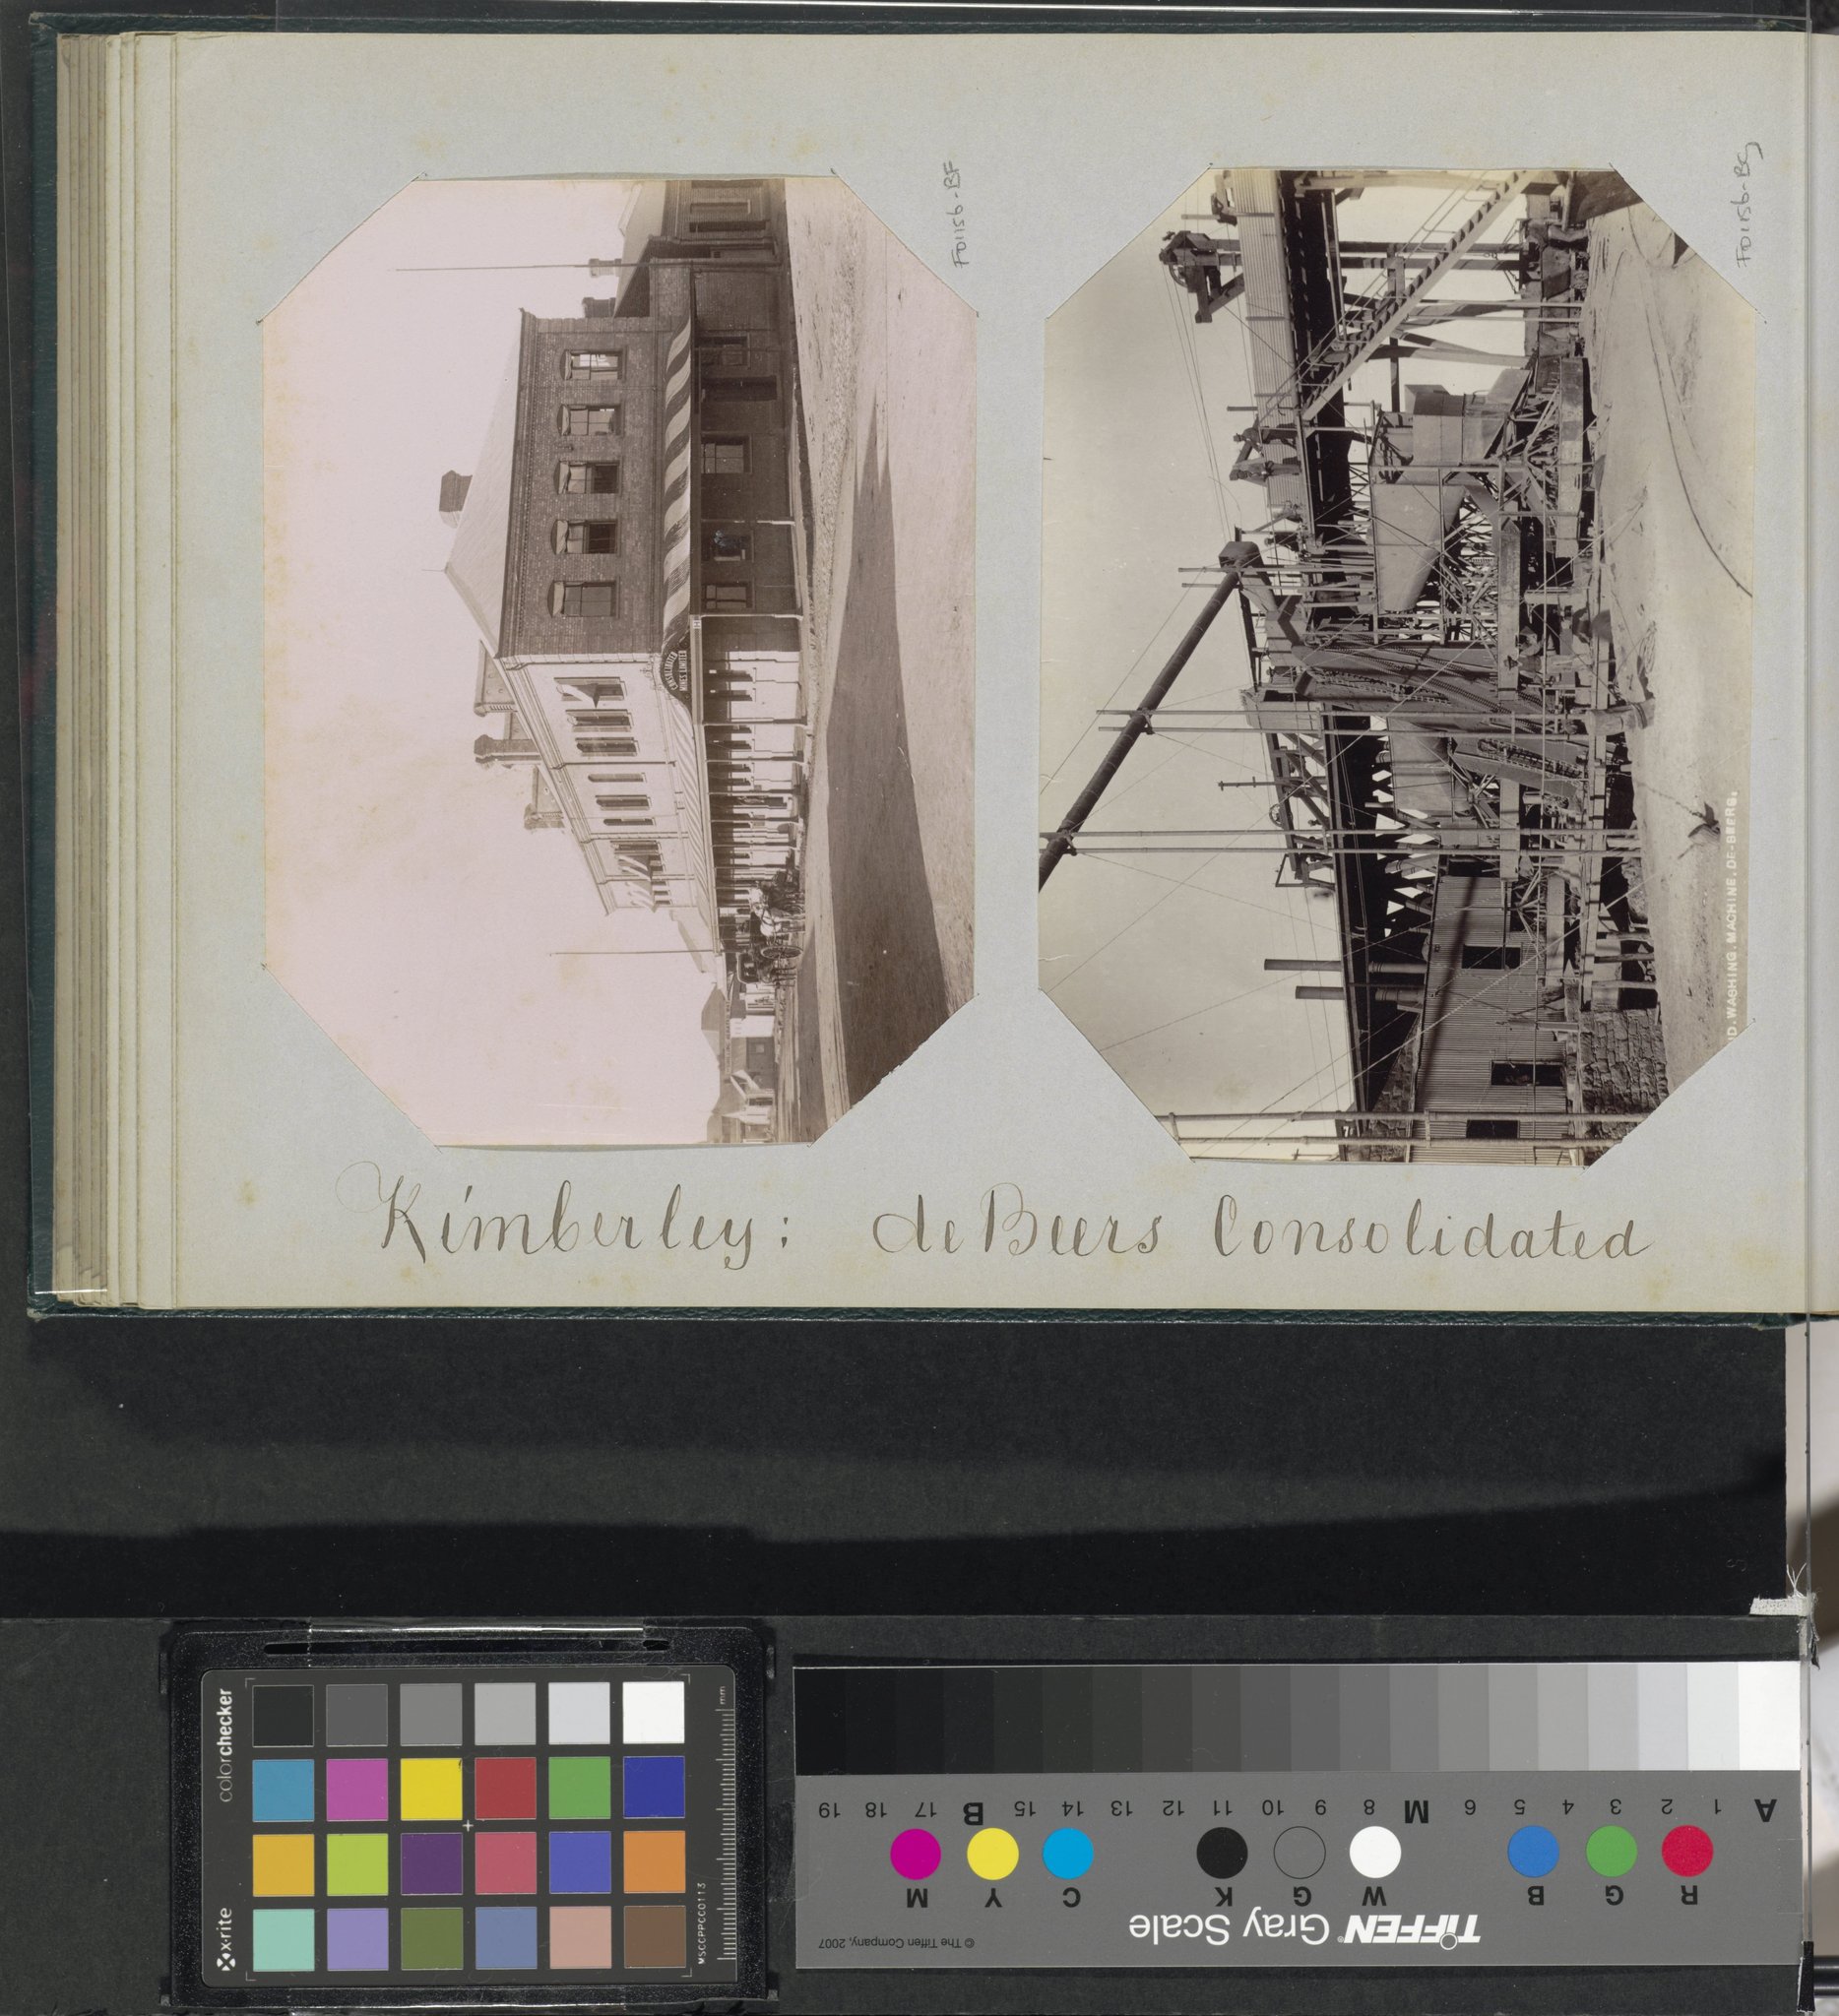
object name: photograph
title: Industriële machine van De Beers bij een diamantmijn te Kimberley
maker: Anonymous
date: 1896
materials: photographic support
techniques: albumen print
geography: kimberley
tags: mining (+ minerals)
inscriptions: annotation: ‘Kimberley: de Beers Consolidated’, inscription: ‘Diamond washing, machine de Beers’